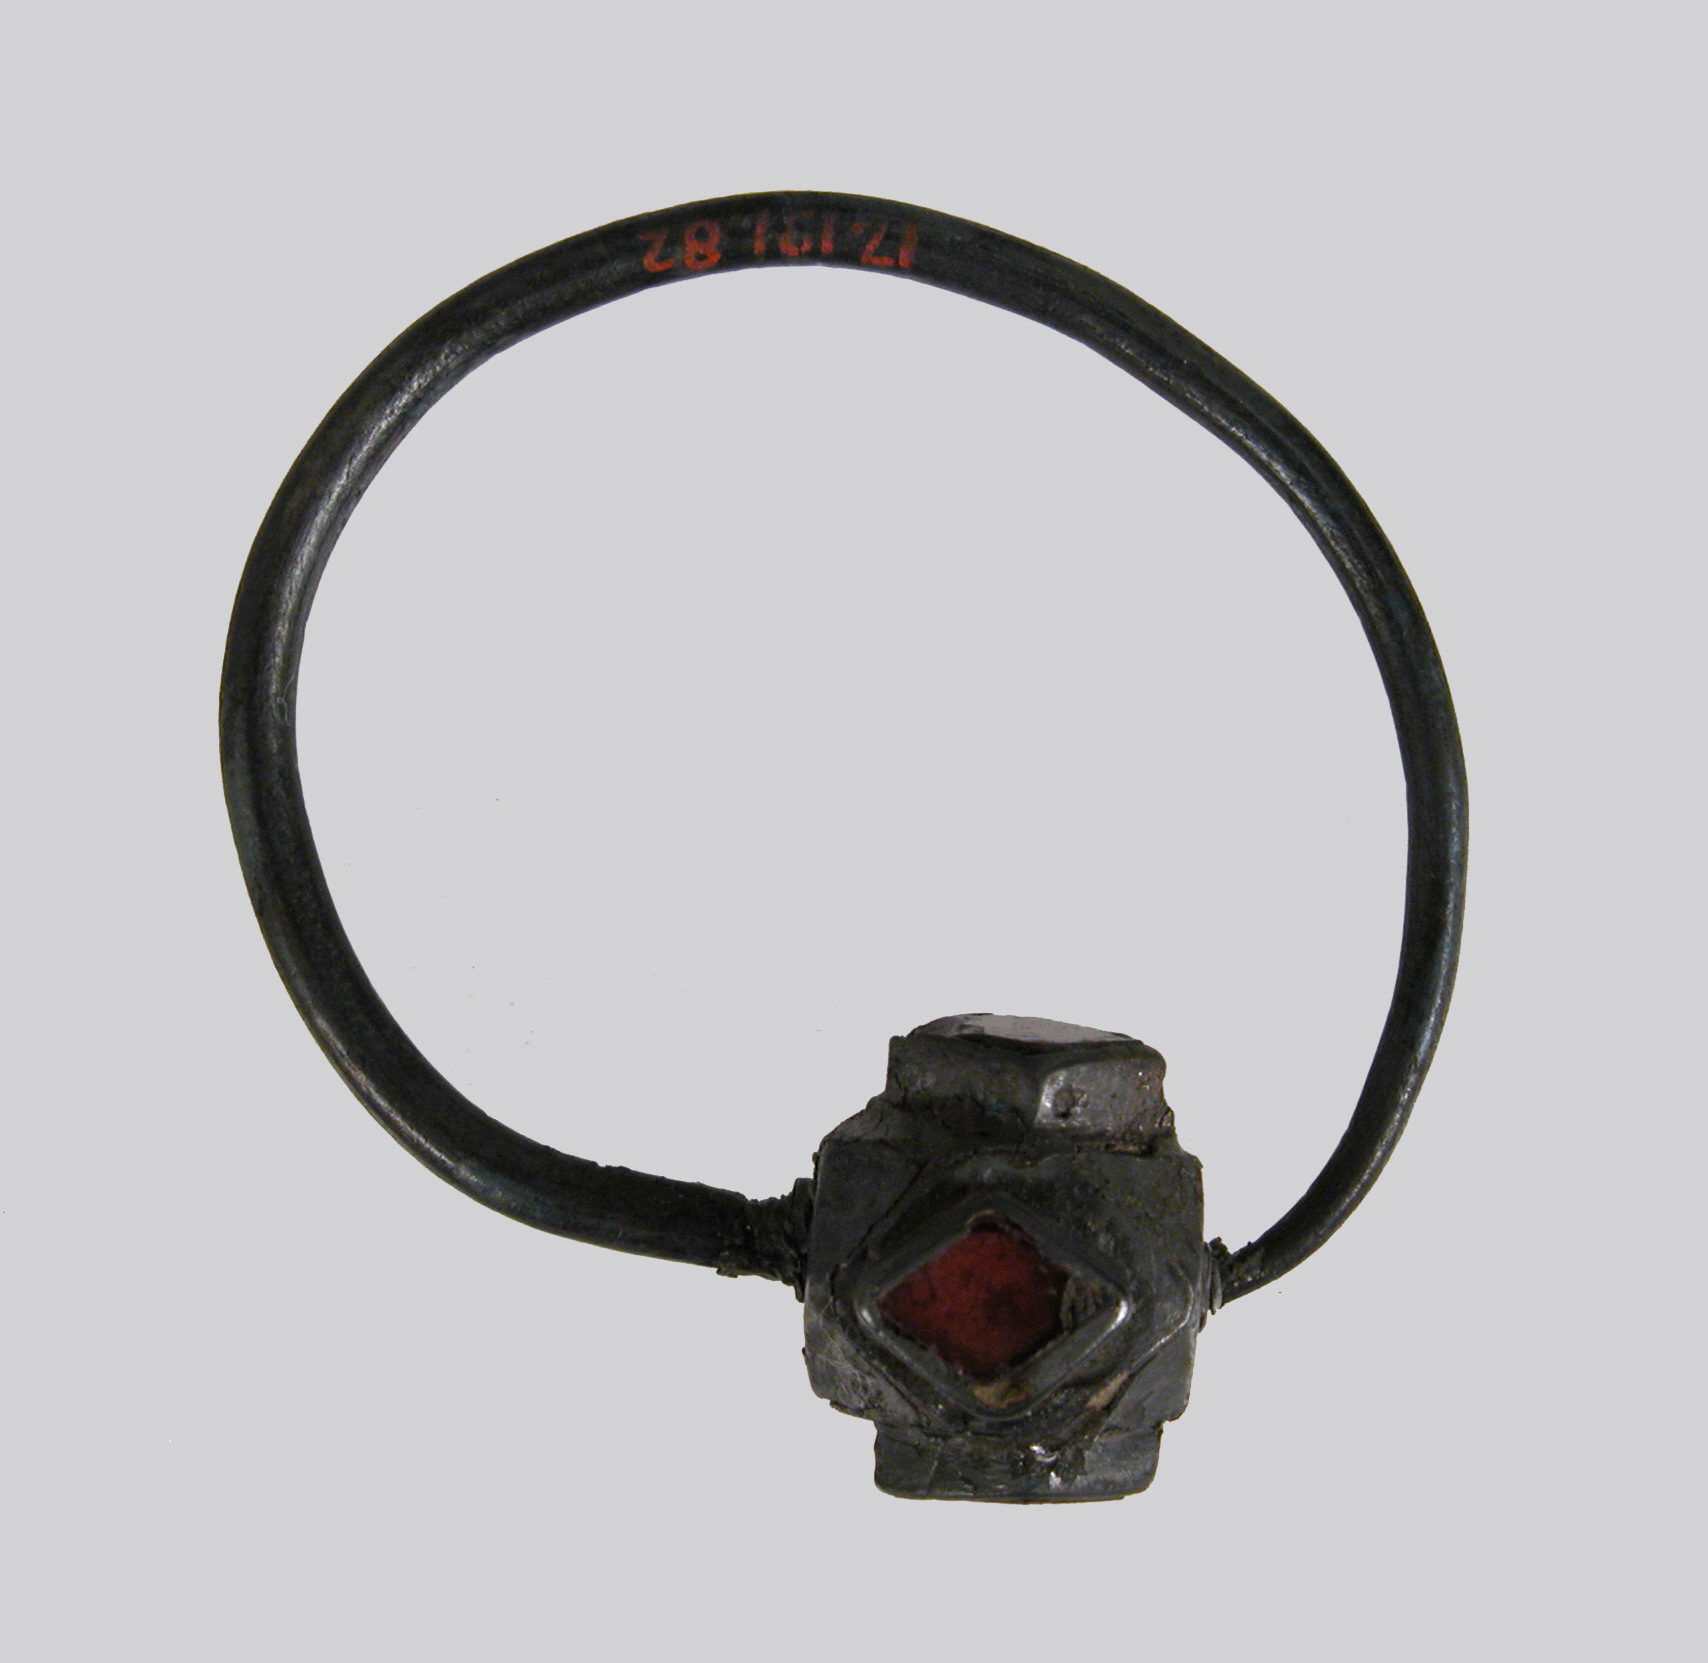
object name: earring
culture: frankish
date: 501-700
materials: gemstone, glass, paste, silver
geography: northern france